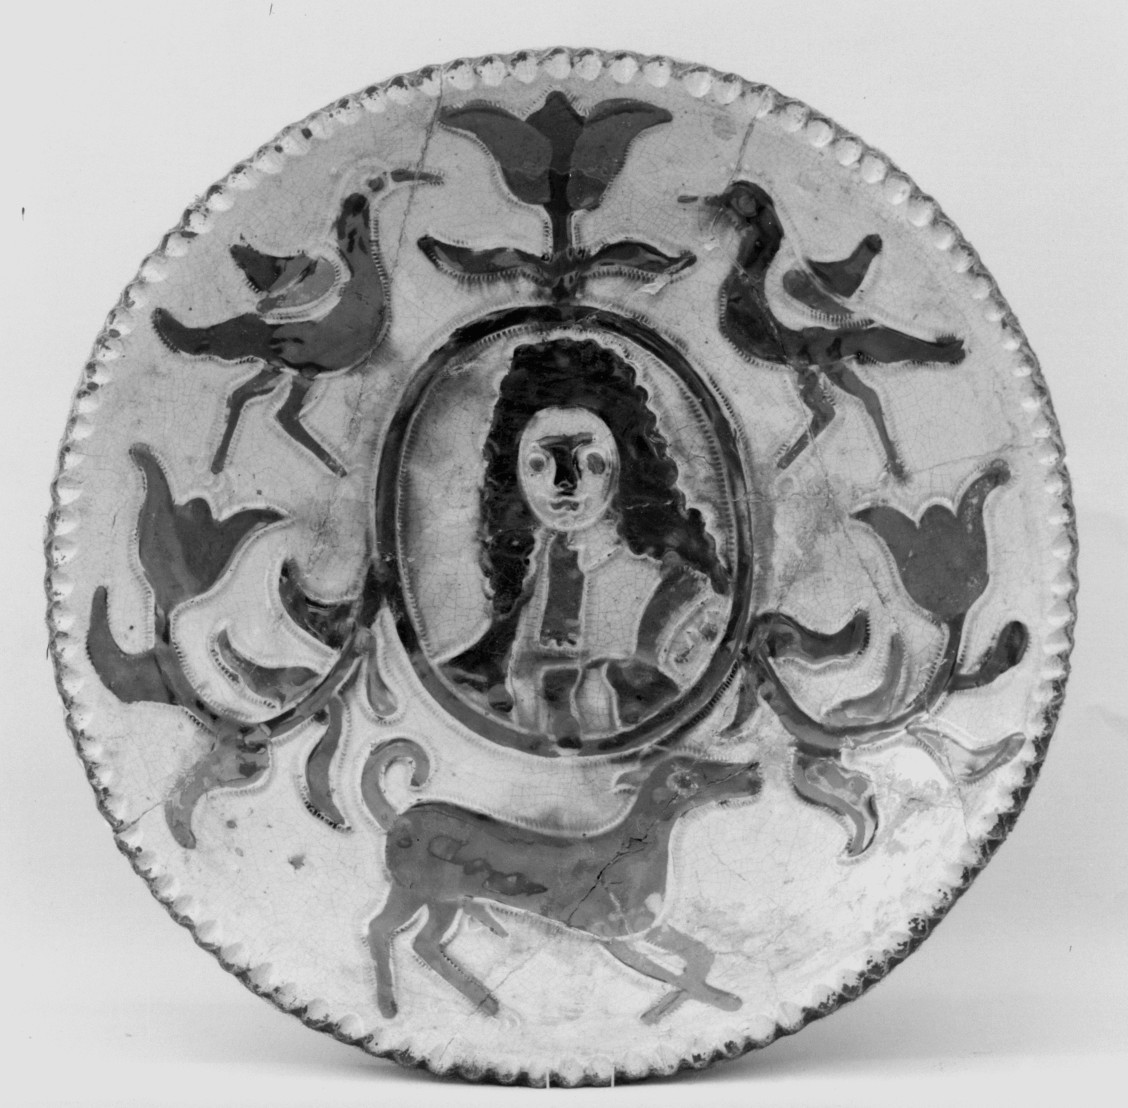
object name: dish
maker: samuel malkin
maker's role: maker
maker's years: 1668-1741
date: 1701-1800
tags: birds,men,flowers